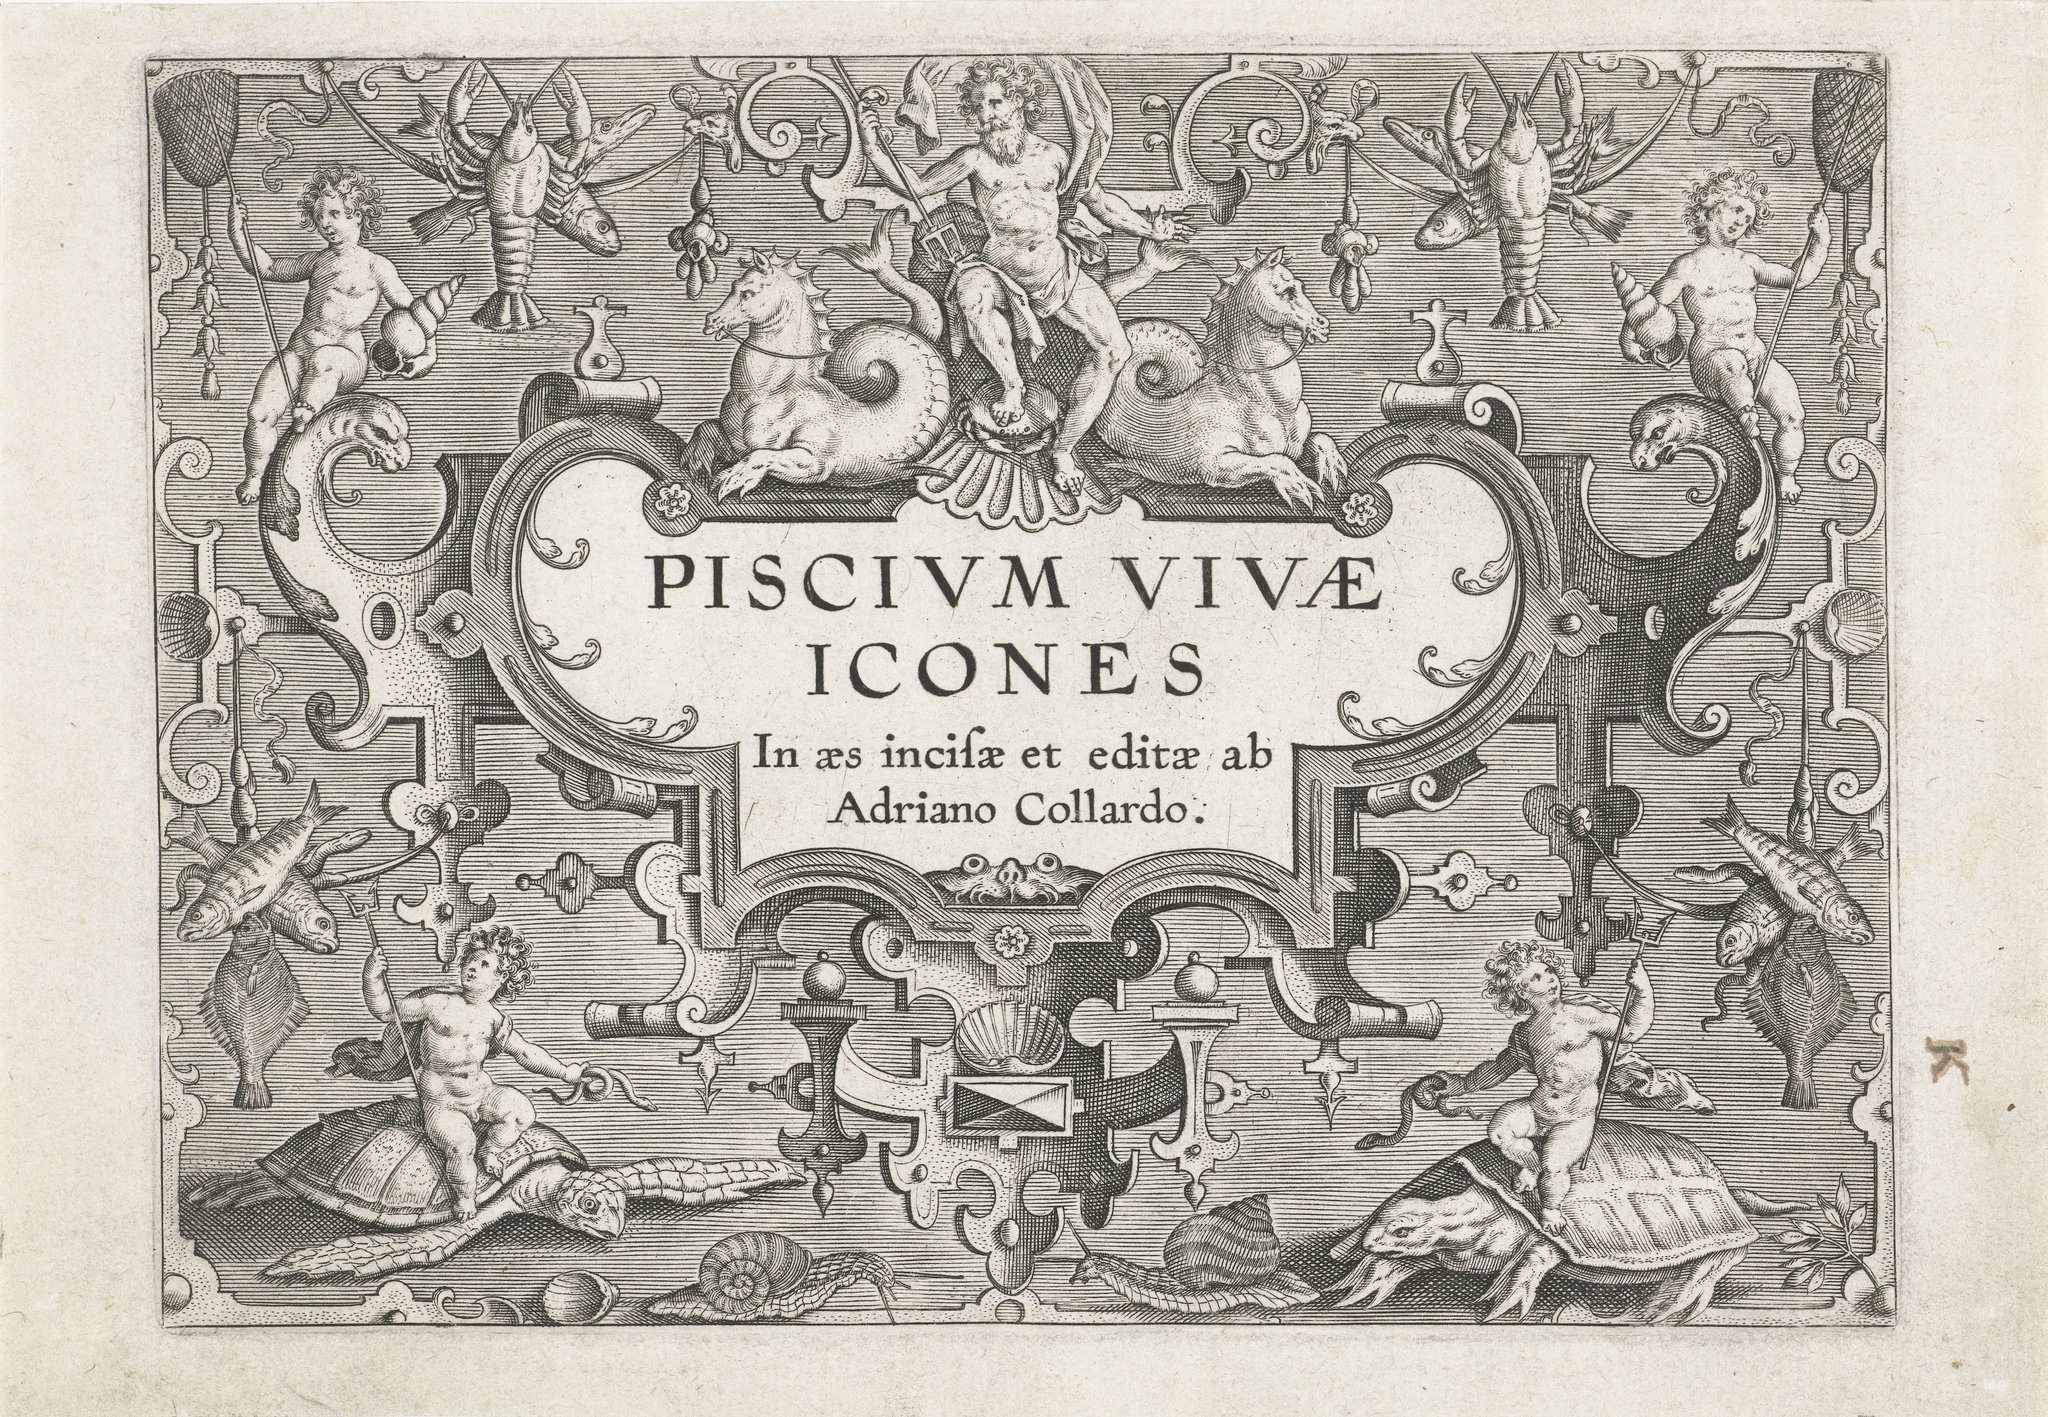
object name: print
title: Titelprent met zeewezens als ornamenten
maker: adriaen collaert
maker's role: draughtsman, print maker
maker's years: 1560-1618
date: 1598-1618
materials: paper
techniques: engraving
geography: antwerp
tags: (story of) neptune (poseidon), tortoises, turtles, title-page, bony fishes (+ ornamental variants of animals)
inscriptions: collector's mark: Lugt 2228, stamp: Lugt 1624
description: Centraal de titel van de prentserie in een met ornamenten versierde cartouche. Boven de cartouche Neptunus op twee zeepaarden. Onder de cartouche twee zeeschildpadden met putti op hun rug. Rondom de cartouche allerlei zeewezens. Dit is de titelprent van een serie met vissen als onderwerp.